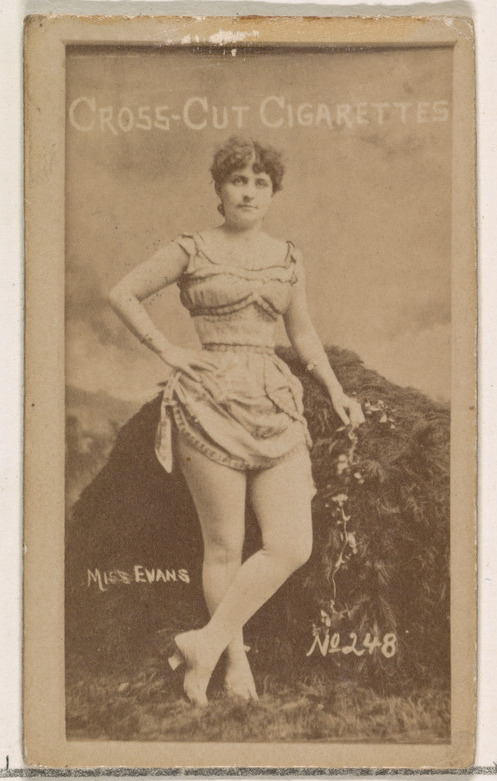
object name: print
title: Card Number 248, Miss Evans, from the Actors and Actresses series (N145-1) issued by Duke Sons & Co. to promote Cross Cut Cigarettes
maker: w. duke, sons & co.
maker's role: publisher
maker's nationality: american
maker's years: 1870-1920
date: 1880-1889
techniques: albumen silver print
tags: portraits,women,actresses